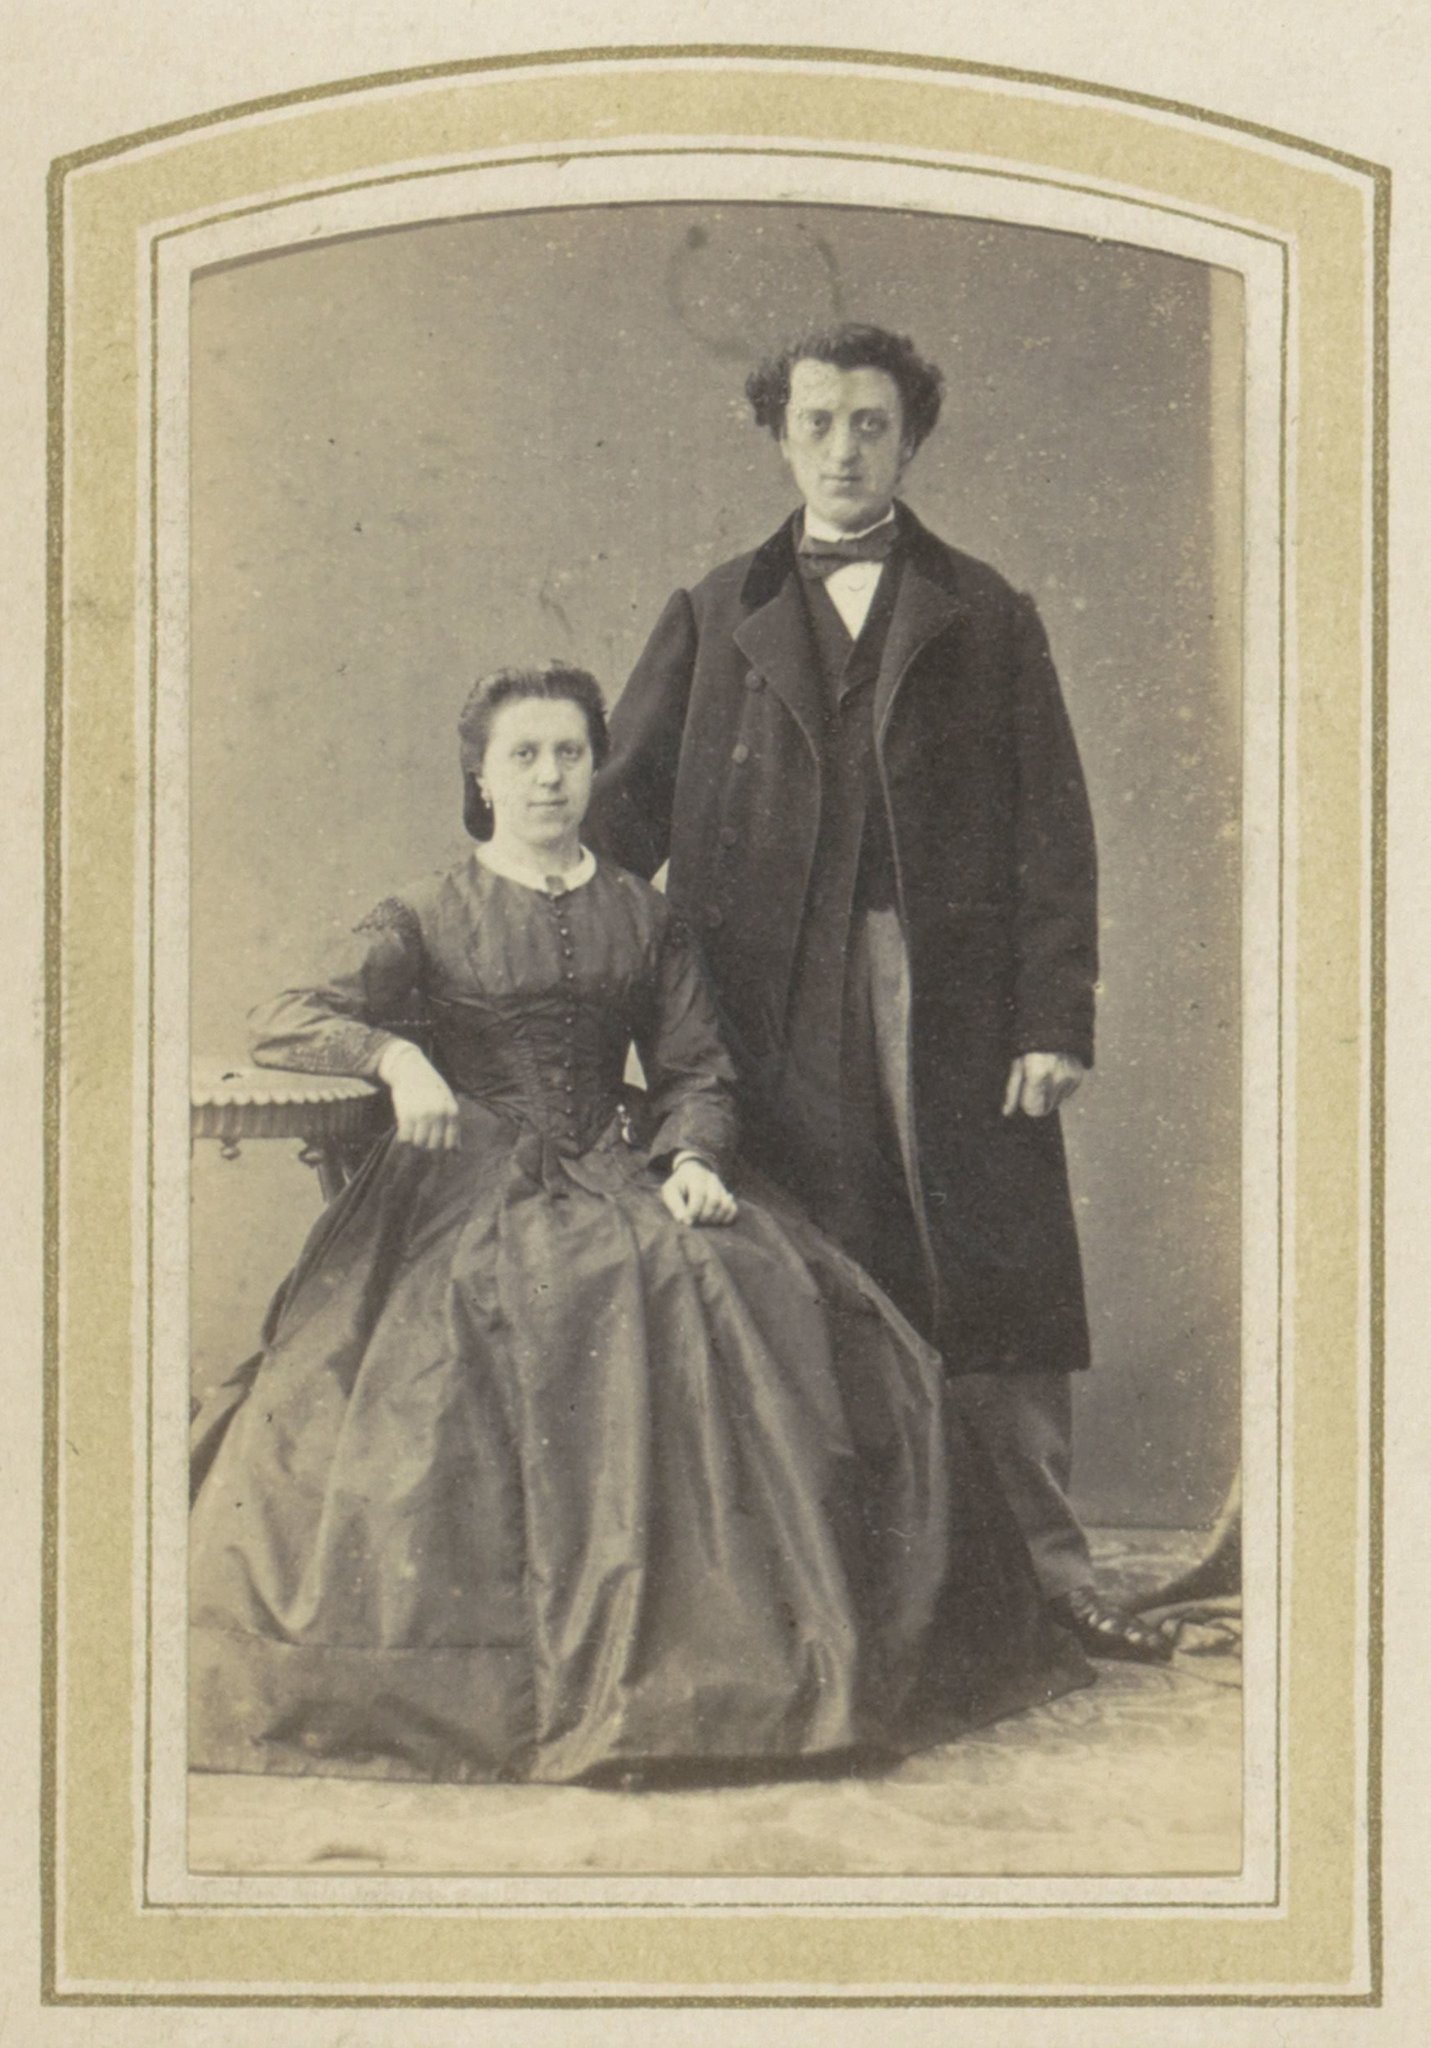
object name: photograph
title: Portret van een man in een lange jas en een vrouw in een jurk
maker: bernardus bruining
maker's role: fotograaf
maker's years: 1834-1900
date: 1860-1877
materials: cardboard, paper, photographic support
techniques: albumen print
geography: leiden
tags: studio requisites ~ photographer, historical persons, neck-gear ~ clothing, clothing for the upper part of the body, hairdress, dress, gown, coat, cape, leiden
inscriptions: address: ‘Leyden’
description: Onderdeel van Fotoalbum van een Nederlandse familie met 168 cartes-de-visite en kabinetfoto's.